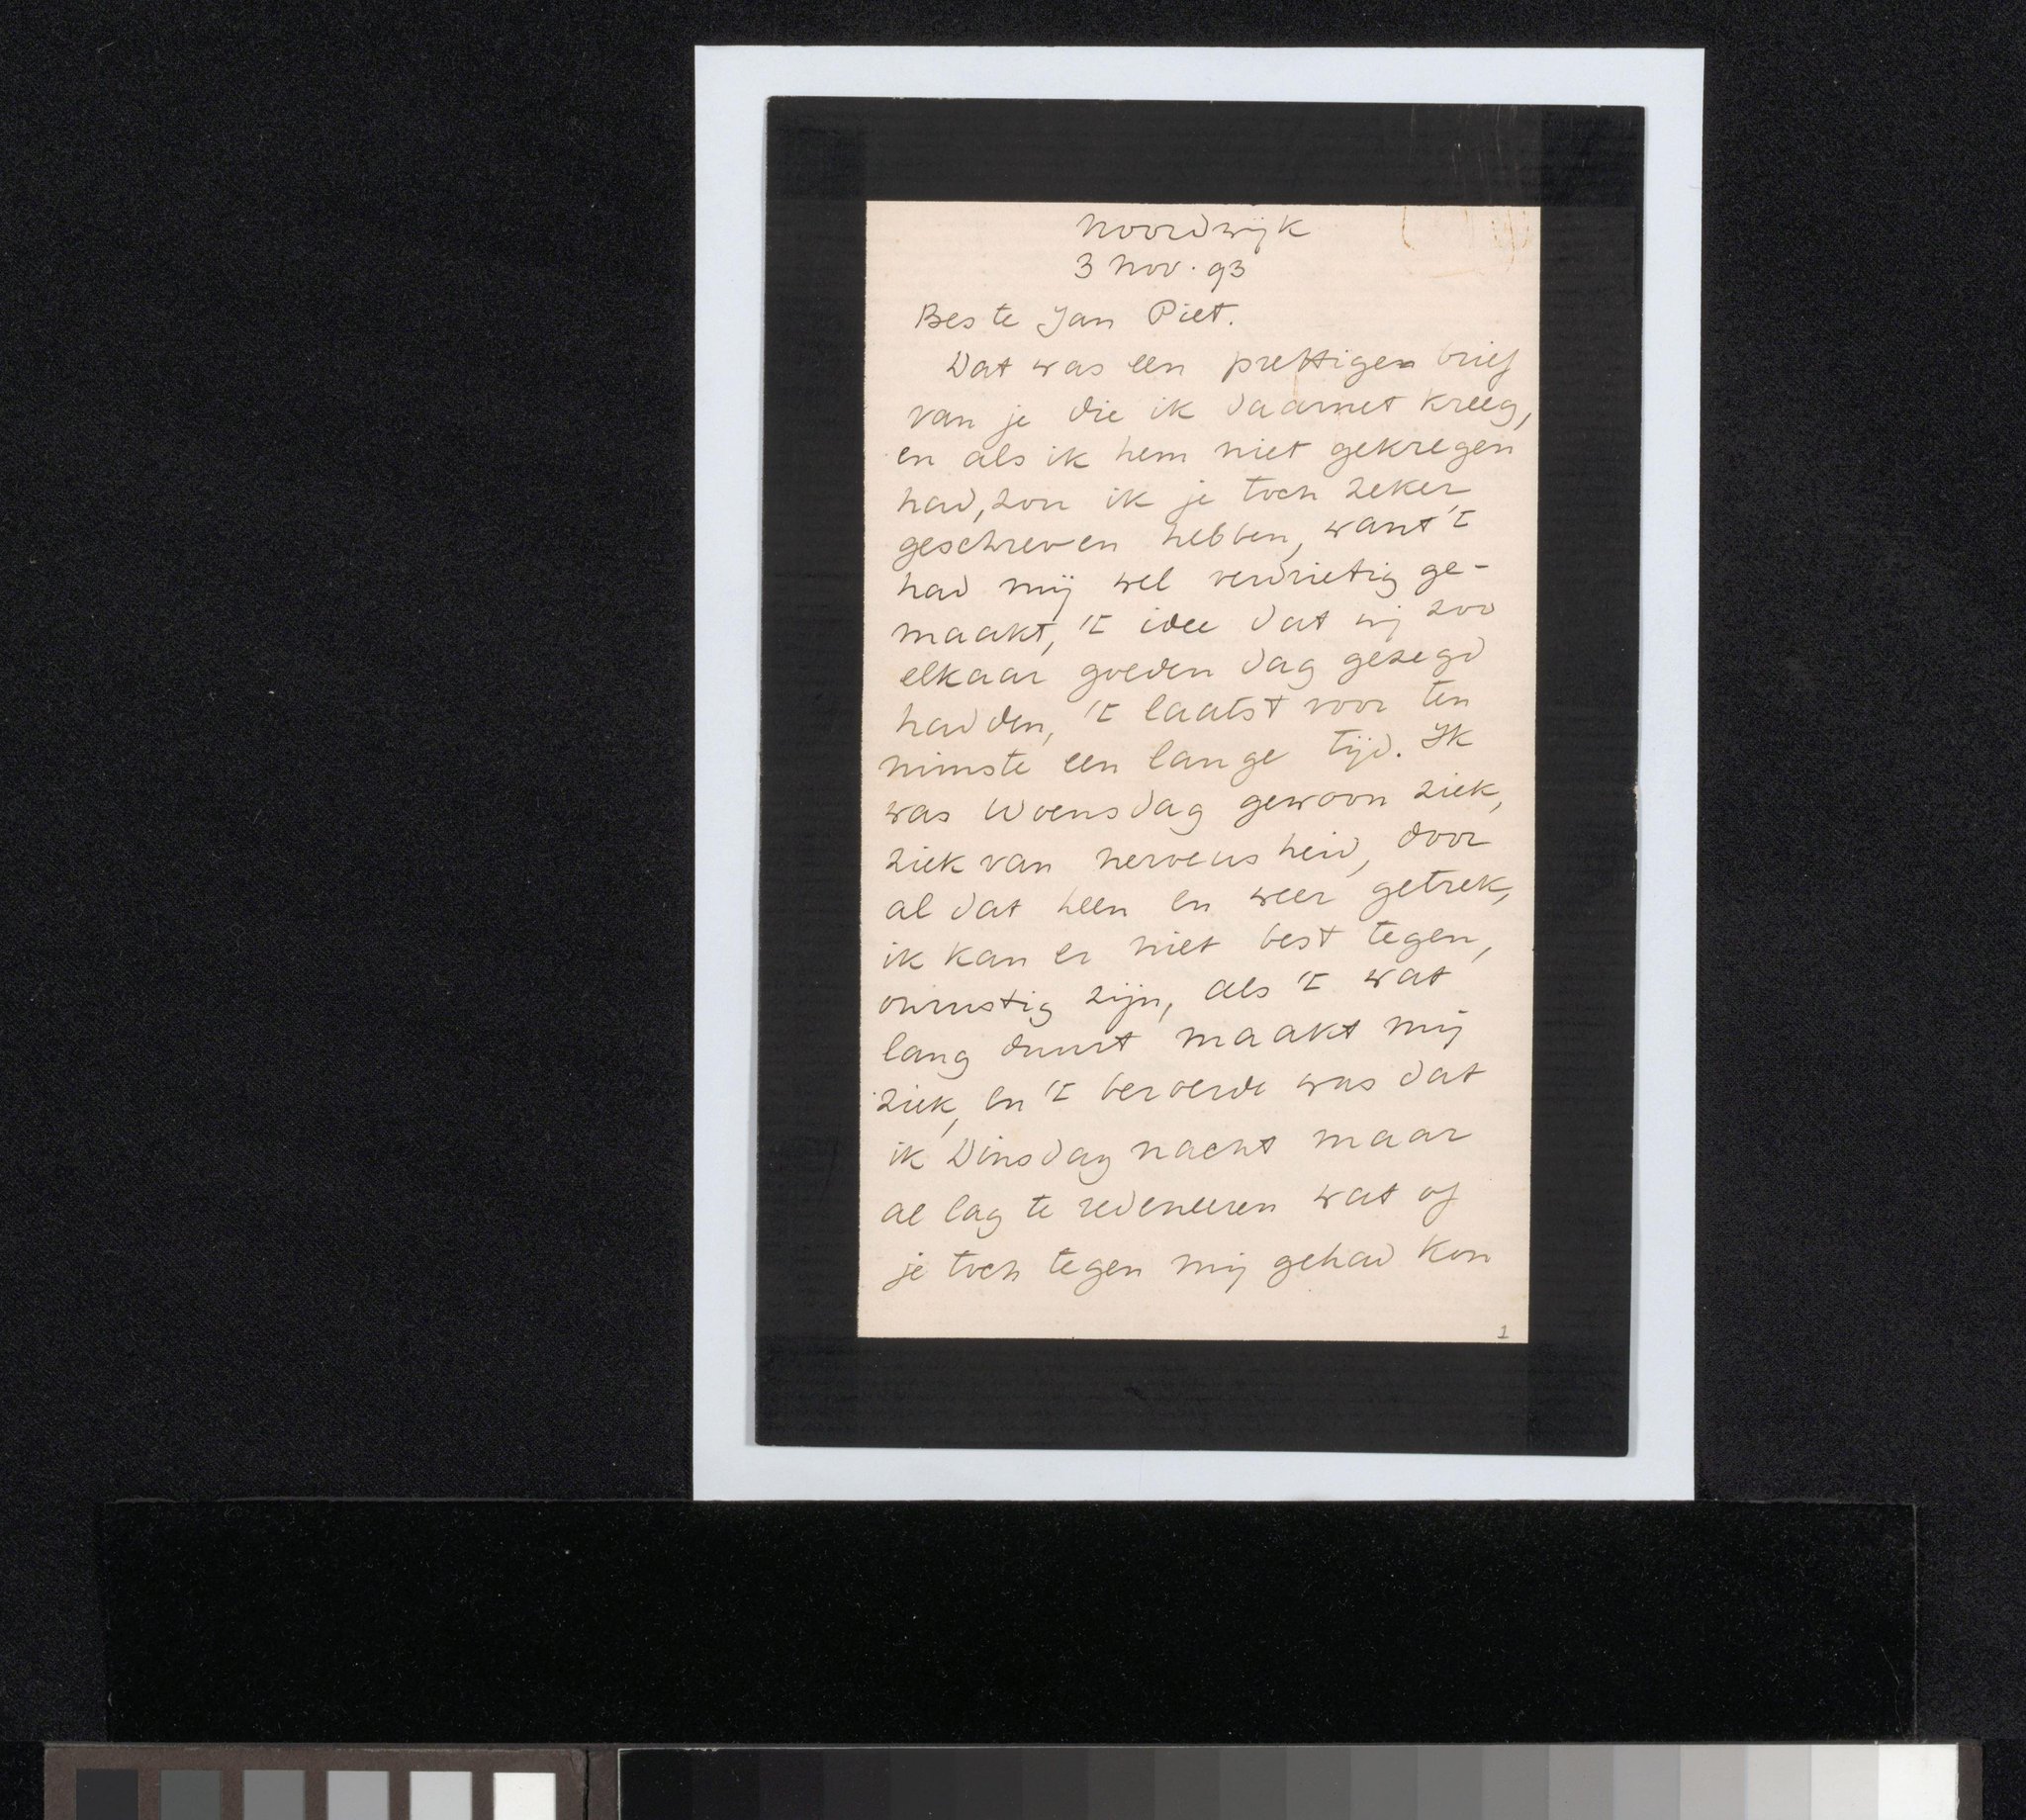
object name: letter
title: Brief aan Jan Veth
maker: richard nicolaüs roland holst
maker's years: 1868-1938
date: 1893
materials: ink, paper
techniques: pen, writing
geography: noordwijk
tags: antwerp, painter, print maker, draughtsman, henry van de velde (1863-1957), dordrecht, designer, jan veth, the hague, willem kloos, herman gorter, henriëtte roland holst-van der schalk, drawing, passions, emotions, affections, music, the graphic arts, family life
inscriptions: collector's mark: ‘RPK’